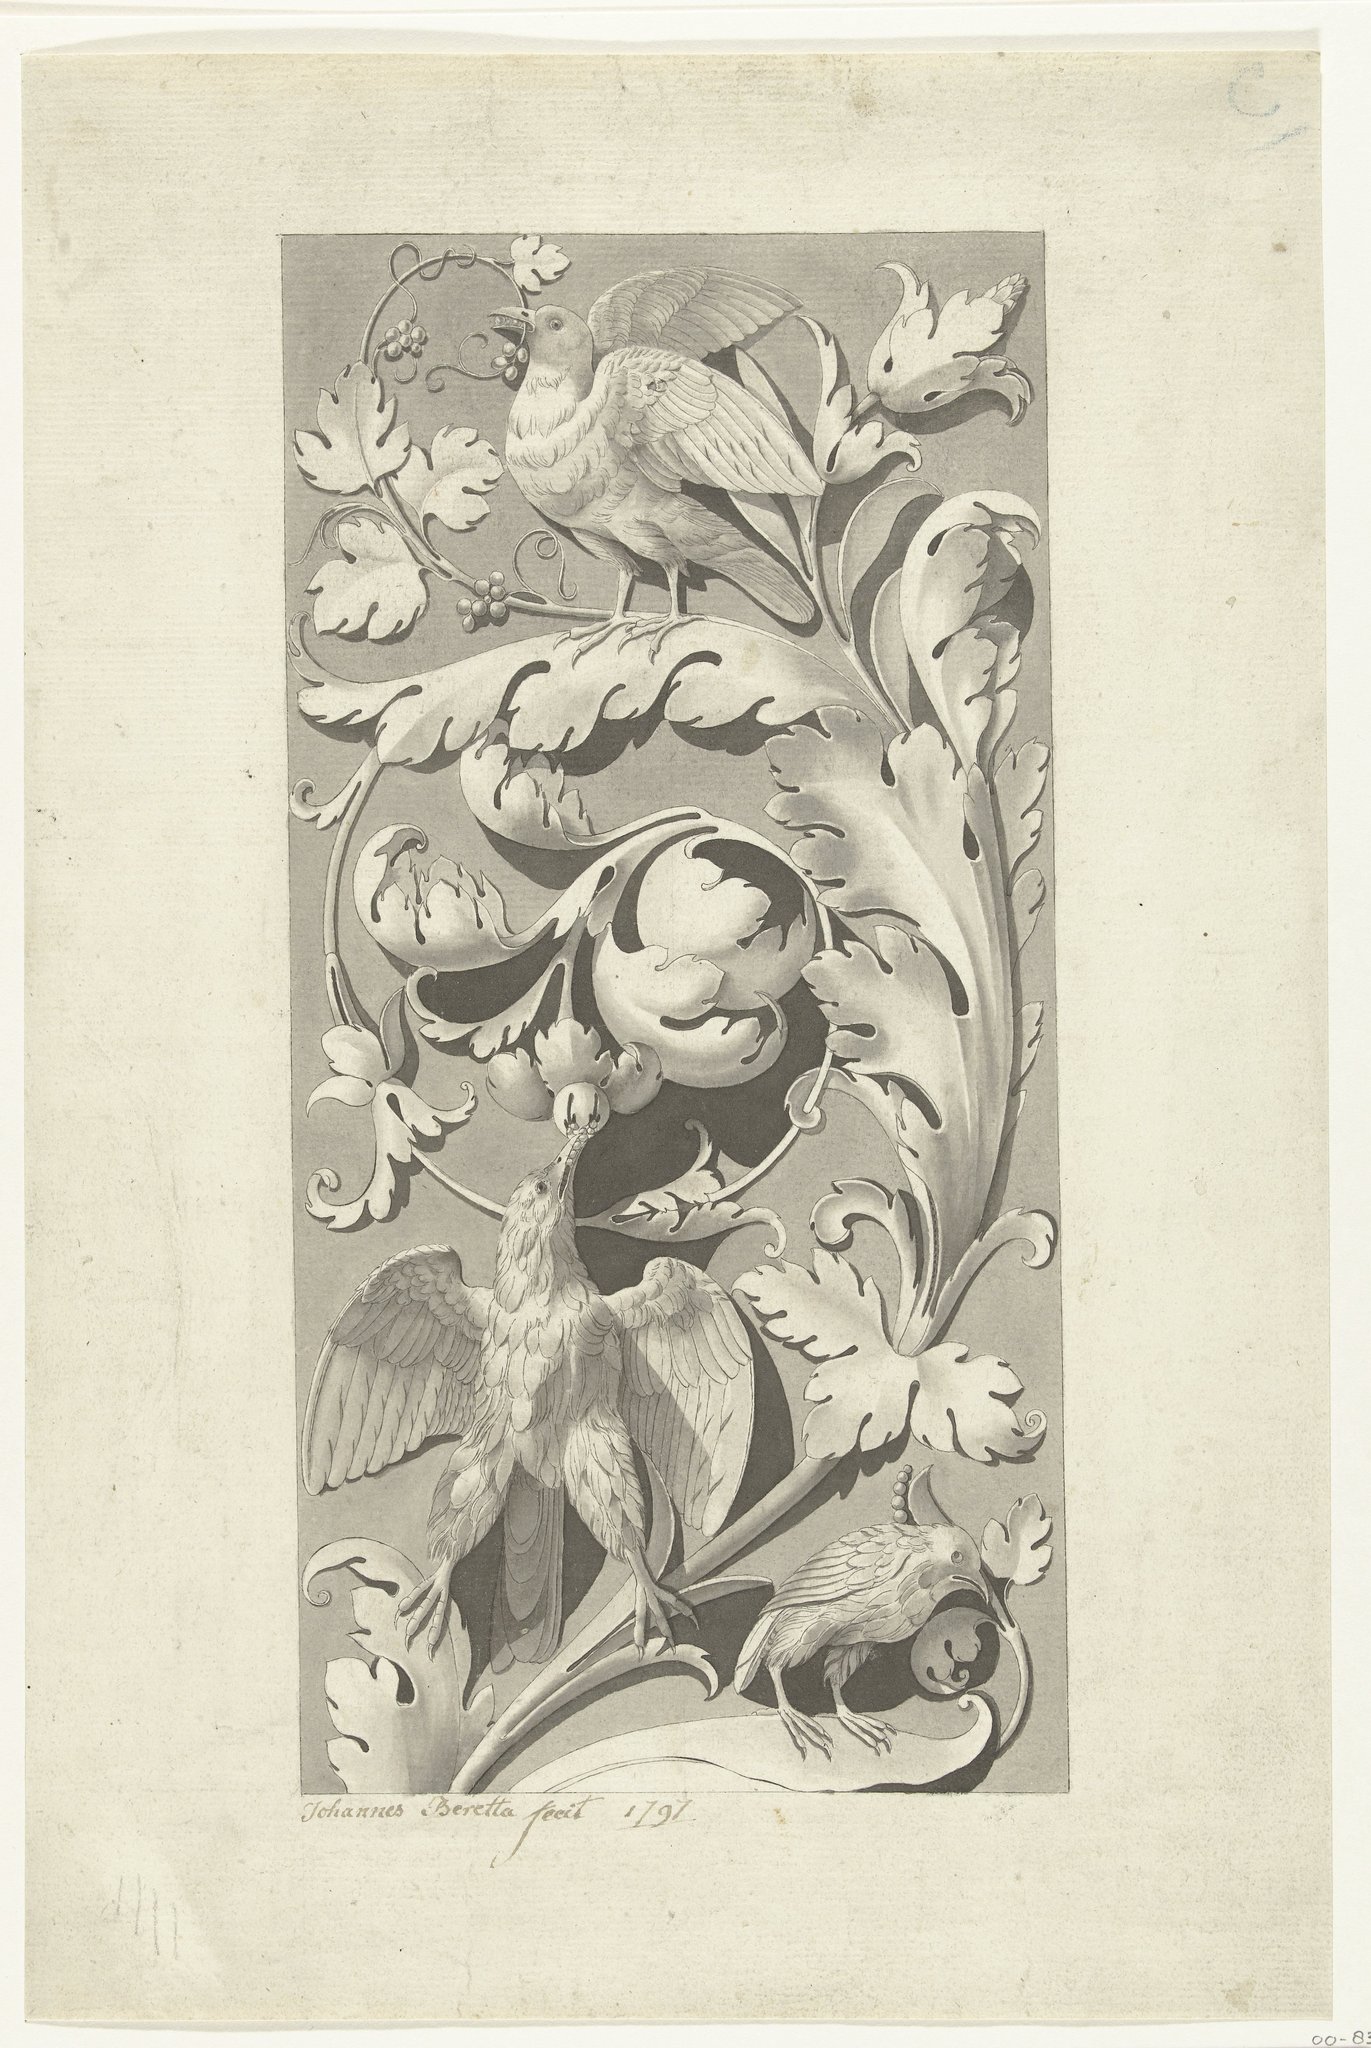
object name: drawing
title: Ornament van bladranken en vogels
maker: johannes beretta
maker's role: draughtsman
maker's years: 1779-1841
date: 1791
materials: ink, paper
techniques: brush, pen